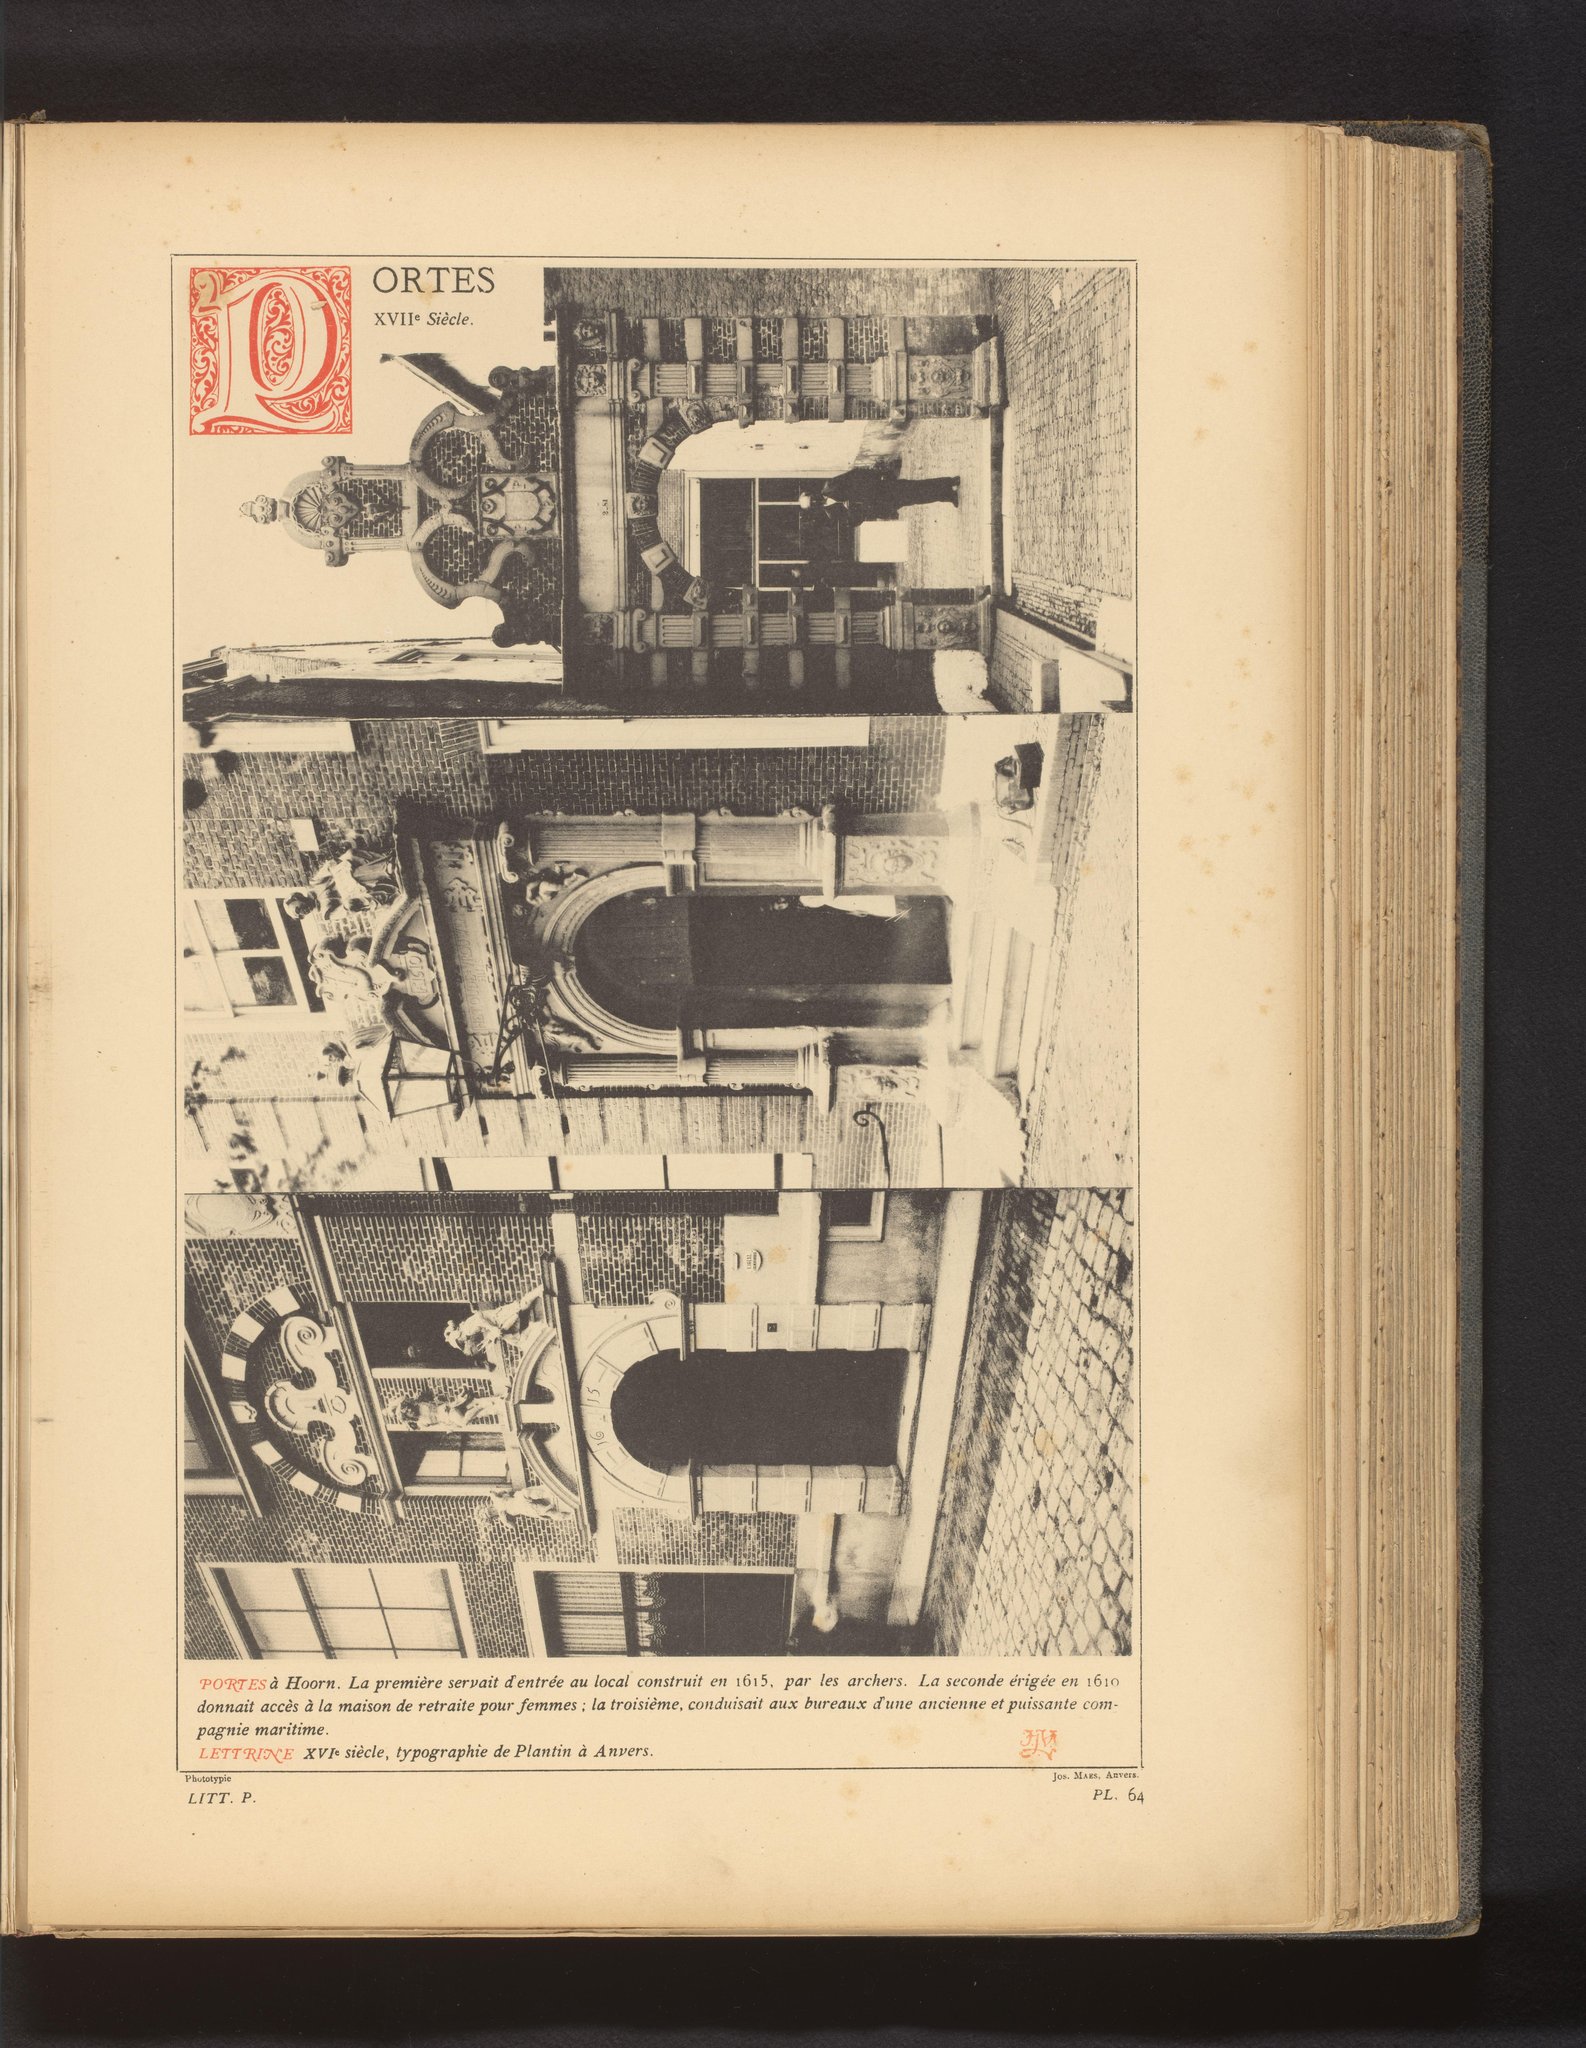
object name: photomechanical print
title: Drie verschillende deuren te Hoorn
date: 1876-1881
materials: paper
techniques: photograph, photolithography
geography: antwerp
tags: door, hoorn (north holland)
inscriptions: monogram: ‘JJvY’, inscription: ‘LITT. P. - PL. 64.’, inscription: ‘PORTES à Hoorn. (...)’